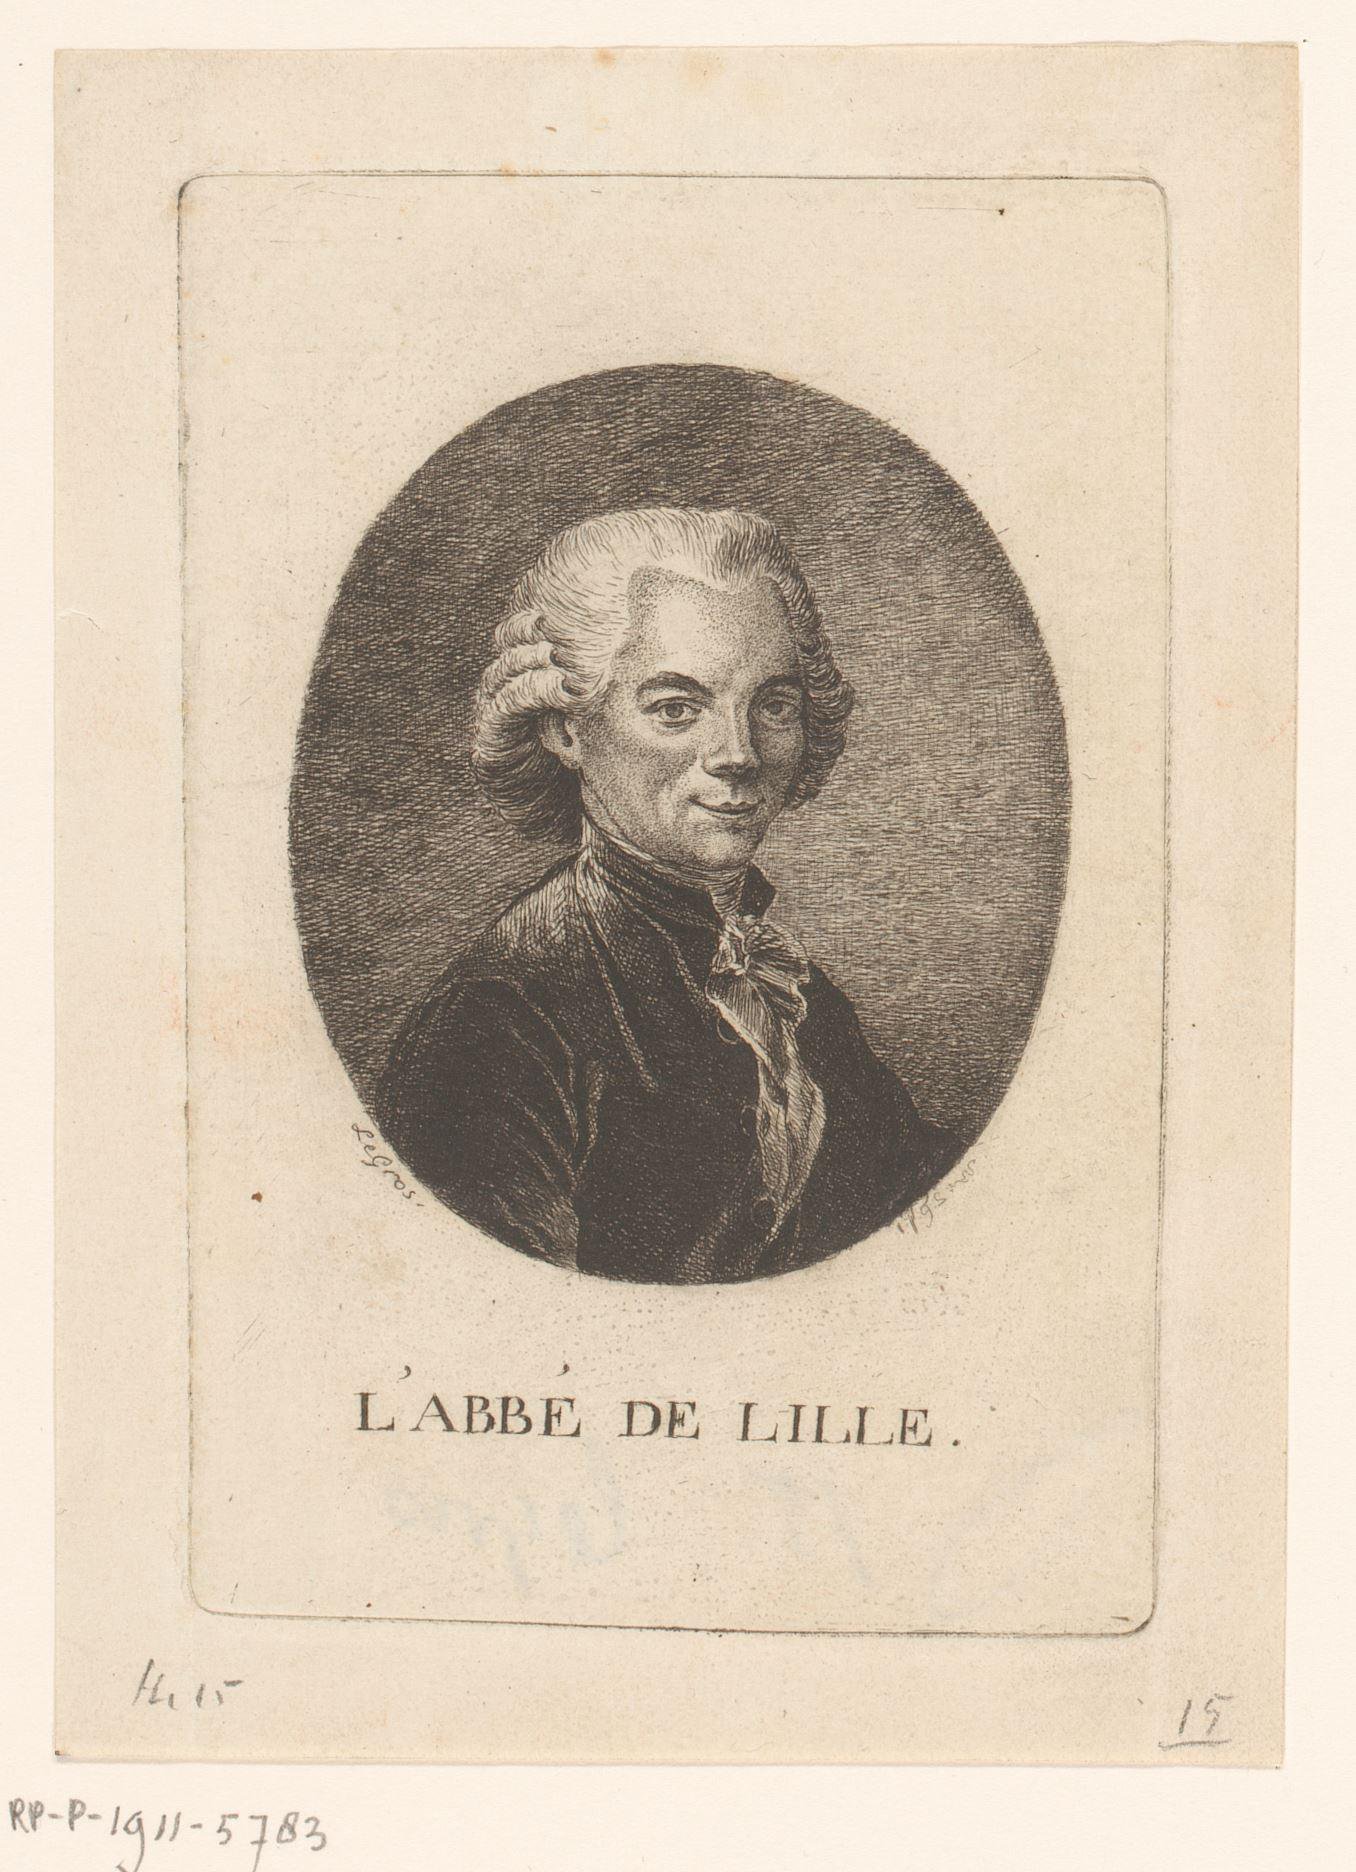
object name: print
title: Portret van Jacques Delille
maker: sauveur legros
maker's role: print maker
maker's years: 1754-1834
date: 1792-1795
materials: paper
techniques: etching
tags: paris, jacques delille, historical persons, portrait of a writer, writer, poet, author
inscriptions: collector's mark: Lugt 2228